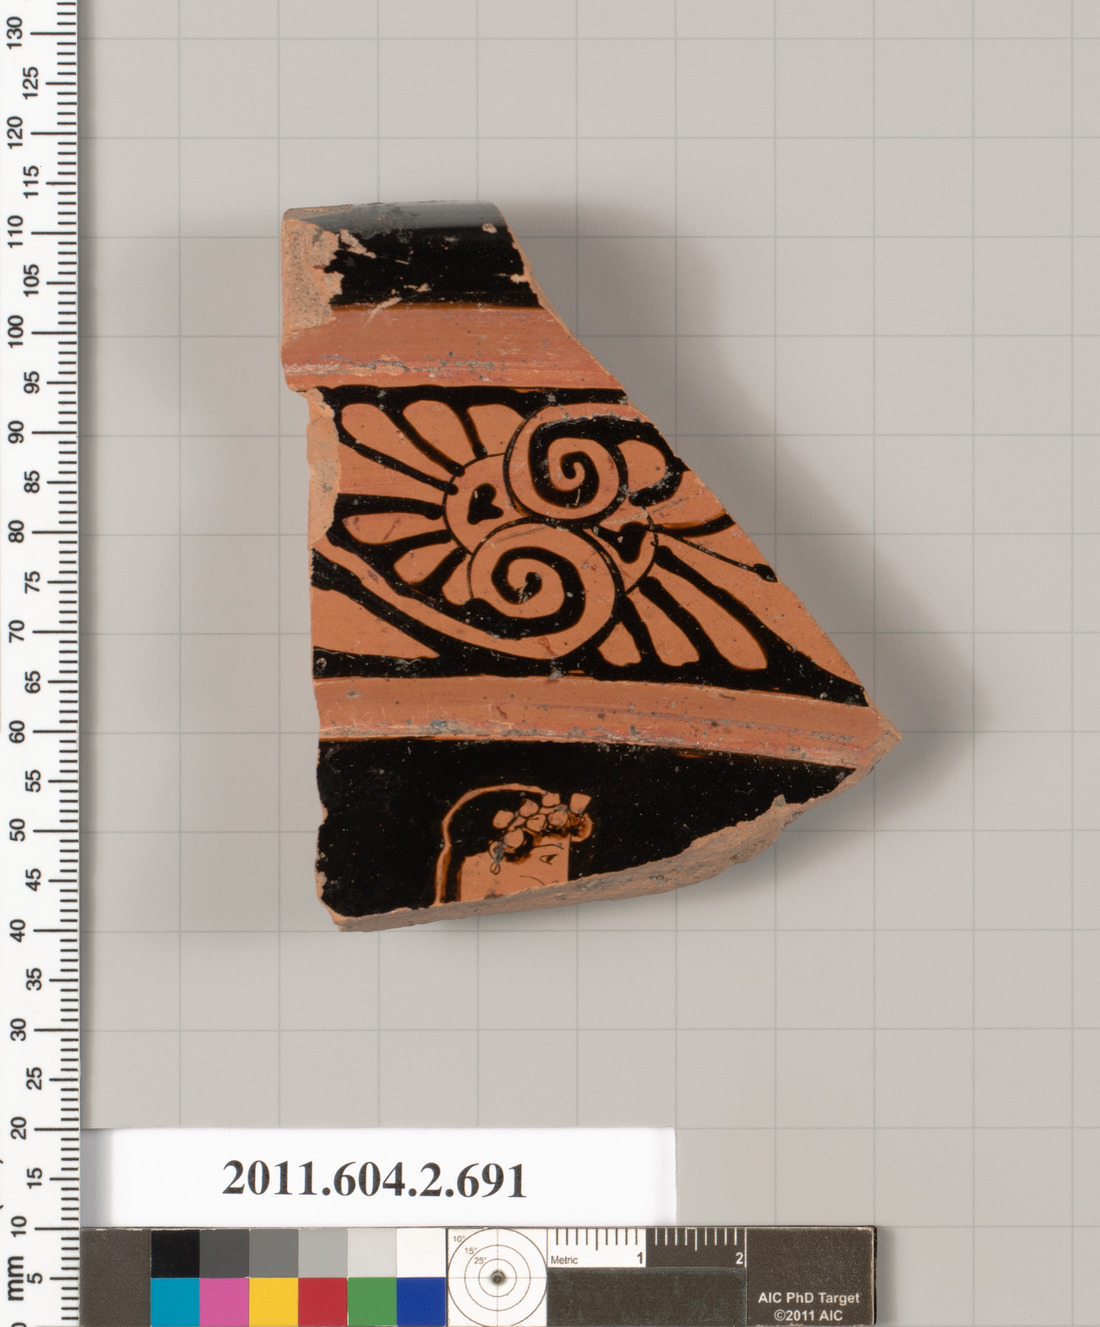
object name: calyx krater fragment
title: Terracotta fragment of a calyx-krater (bowl for mixing wine and water)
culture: greek, attic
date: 460-450 BCE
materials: terracotta